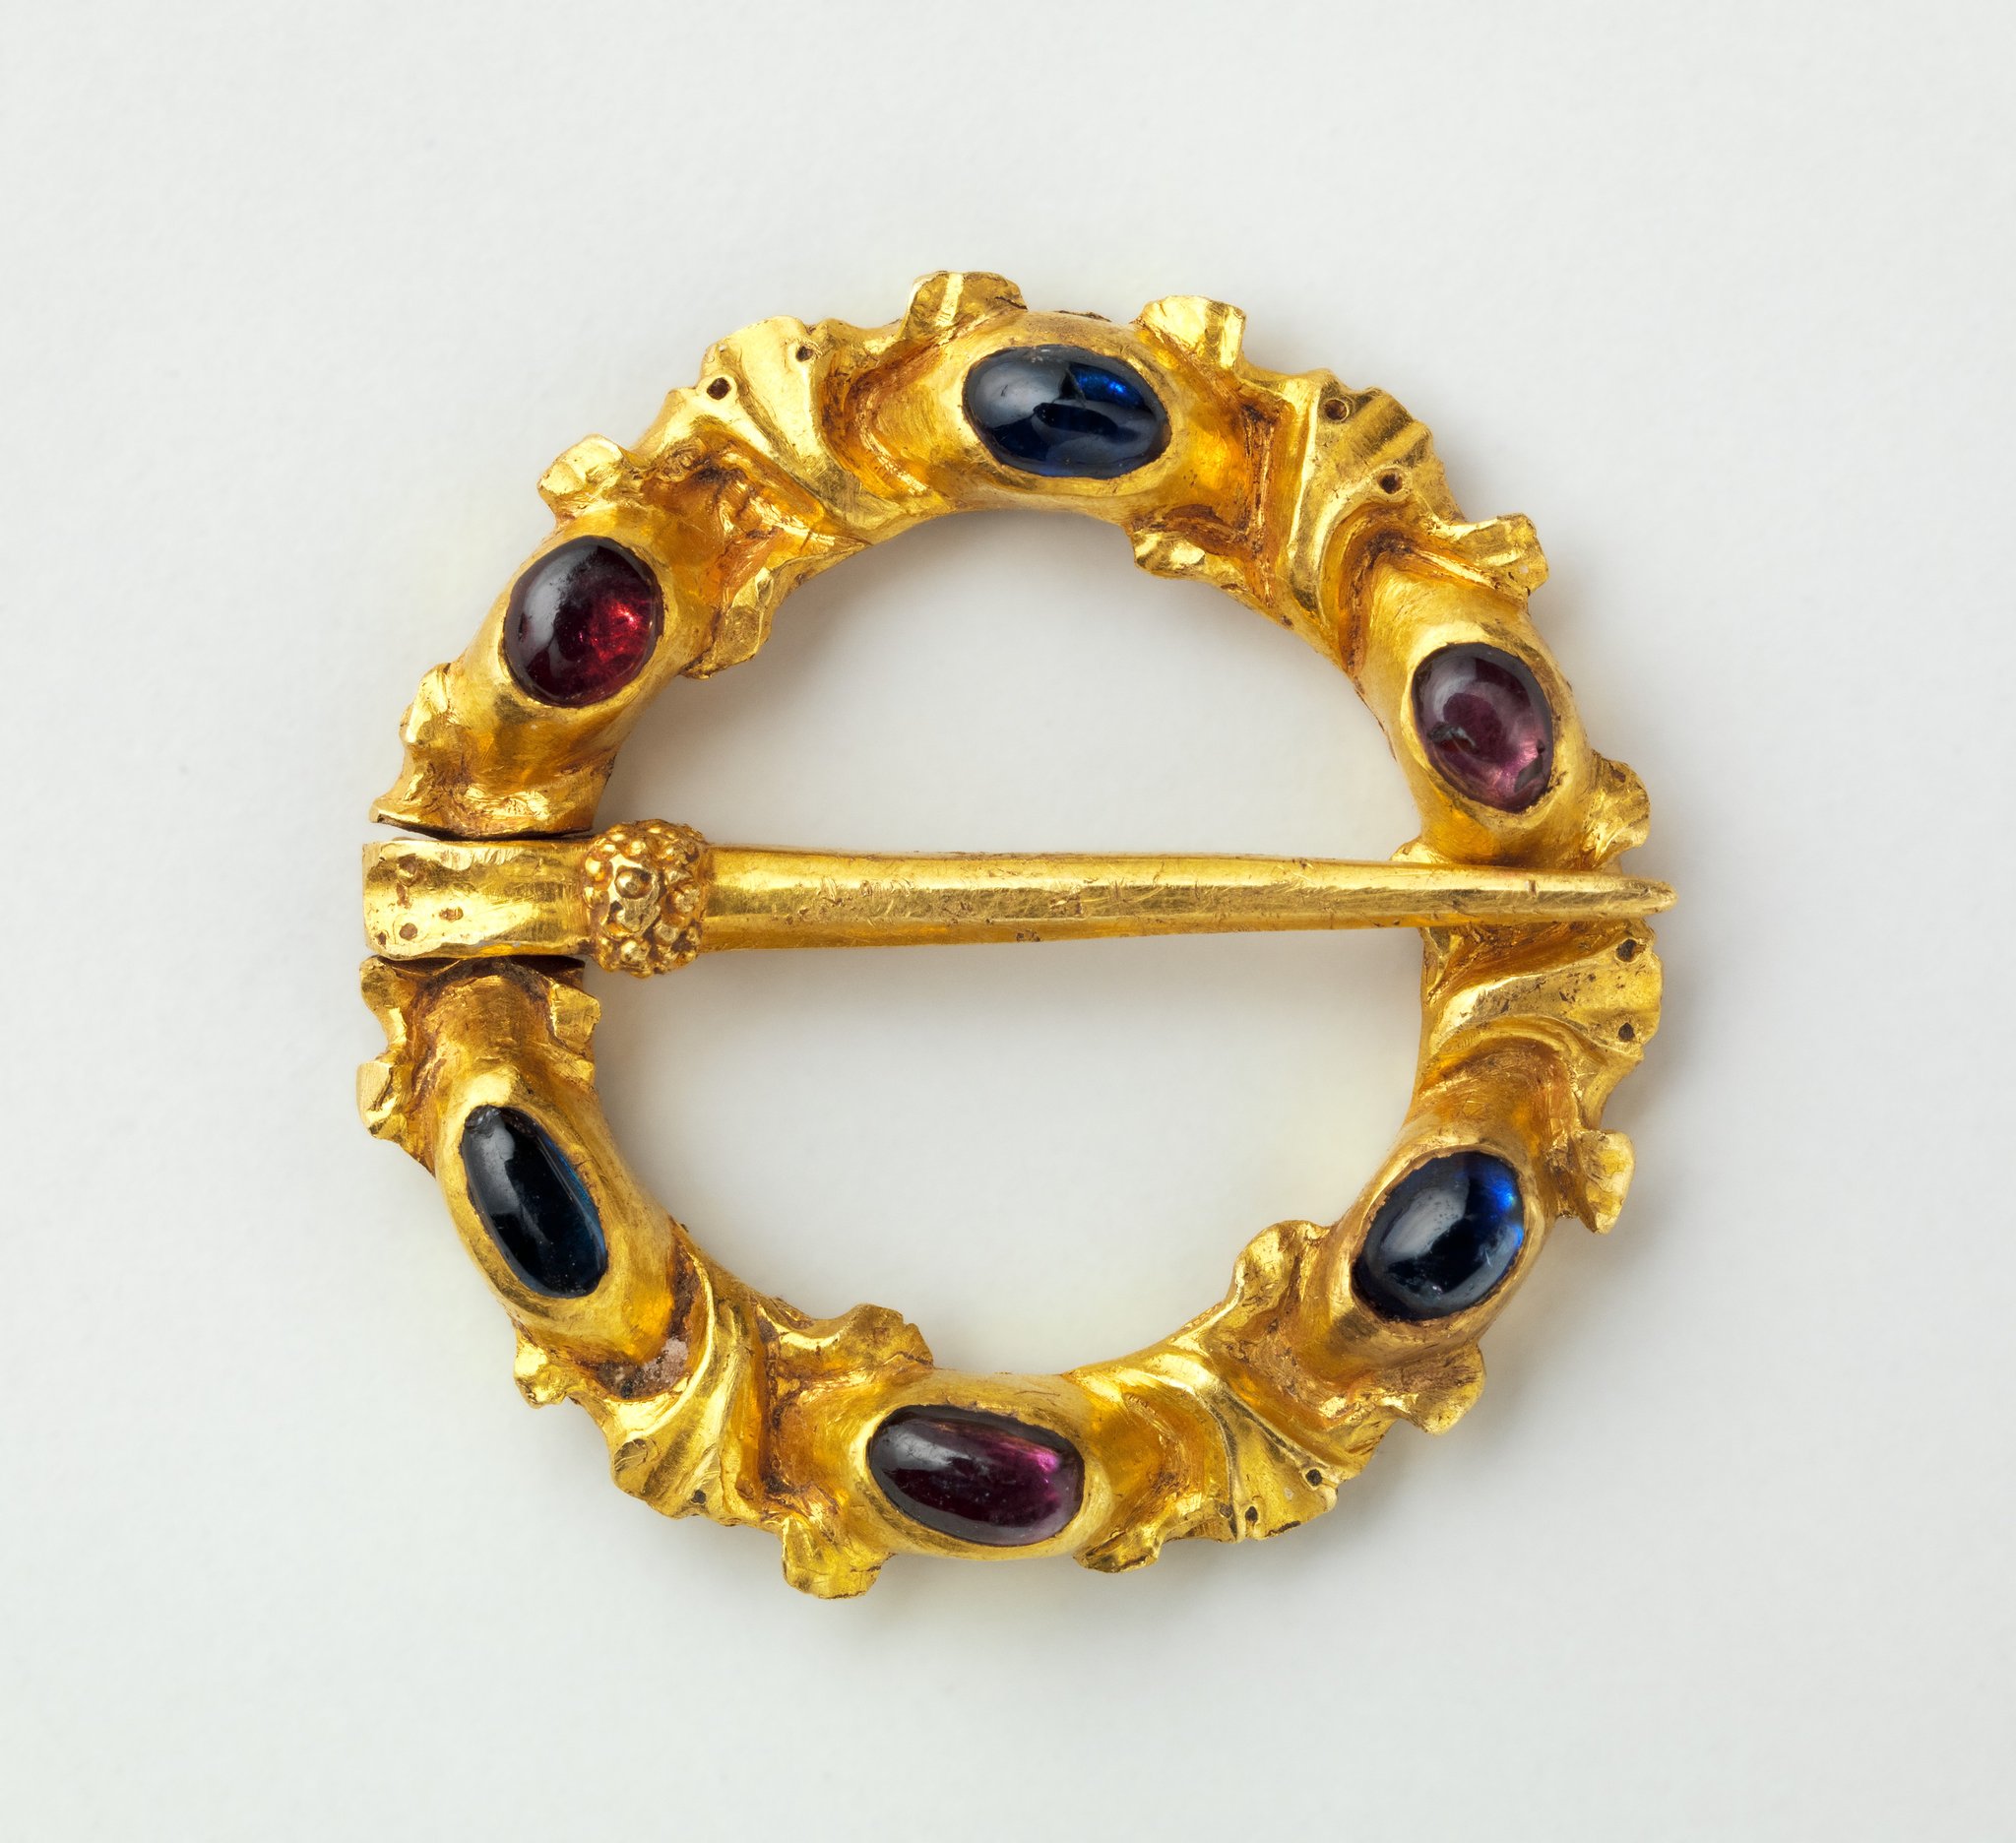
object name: brooch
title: Ring Brooch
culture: british or french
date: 1250-1300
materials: gemstone, gold